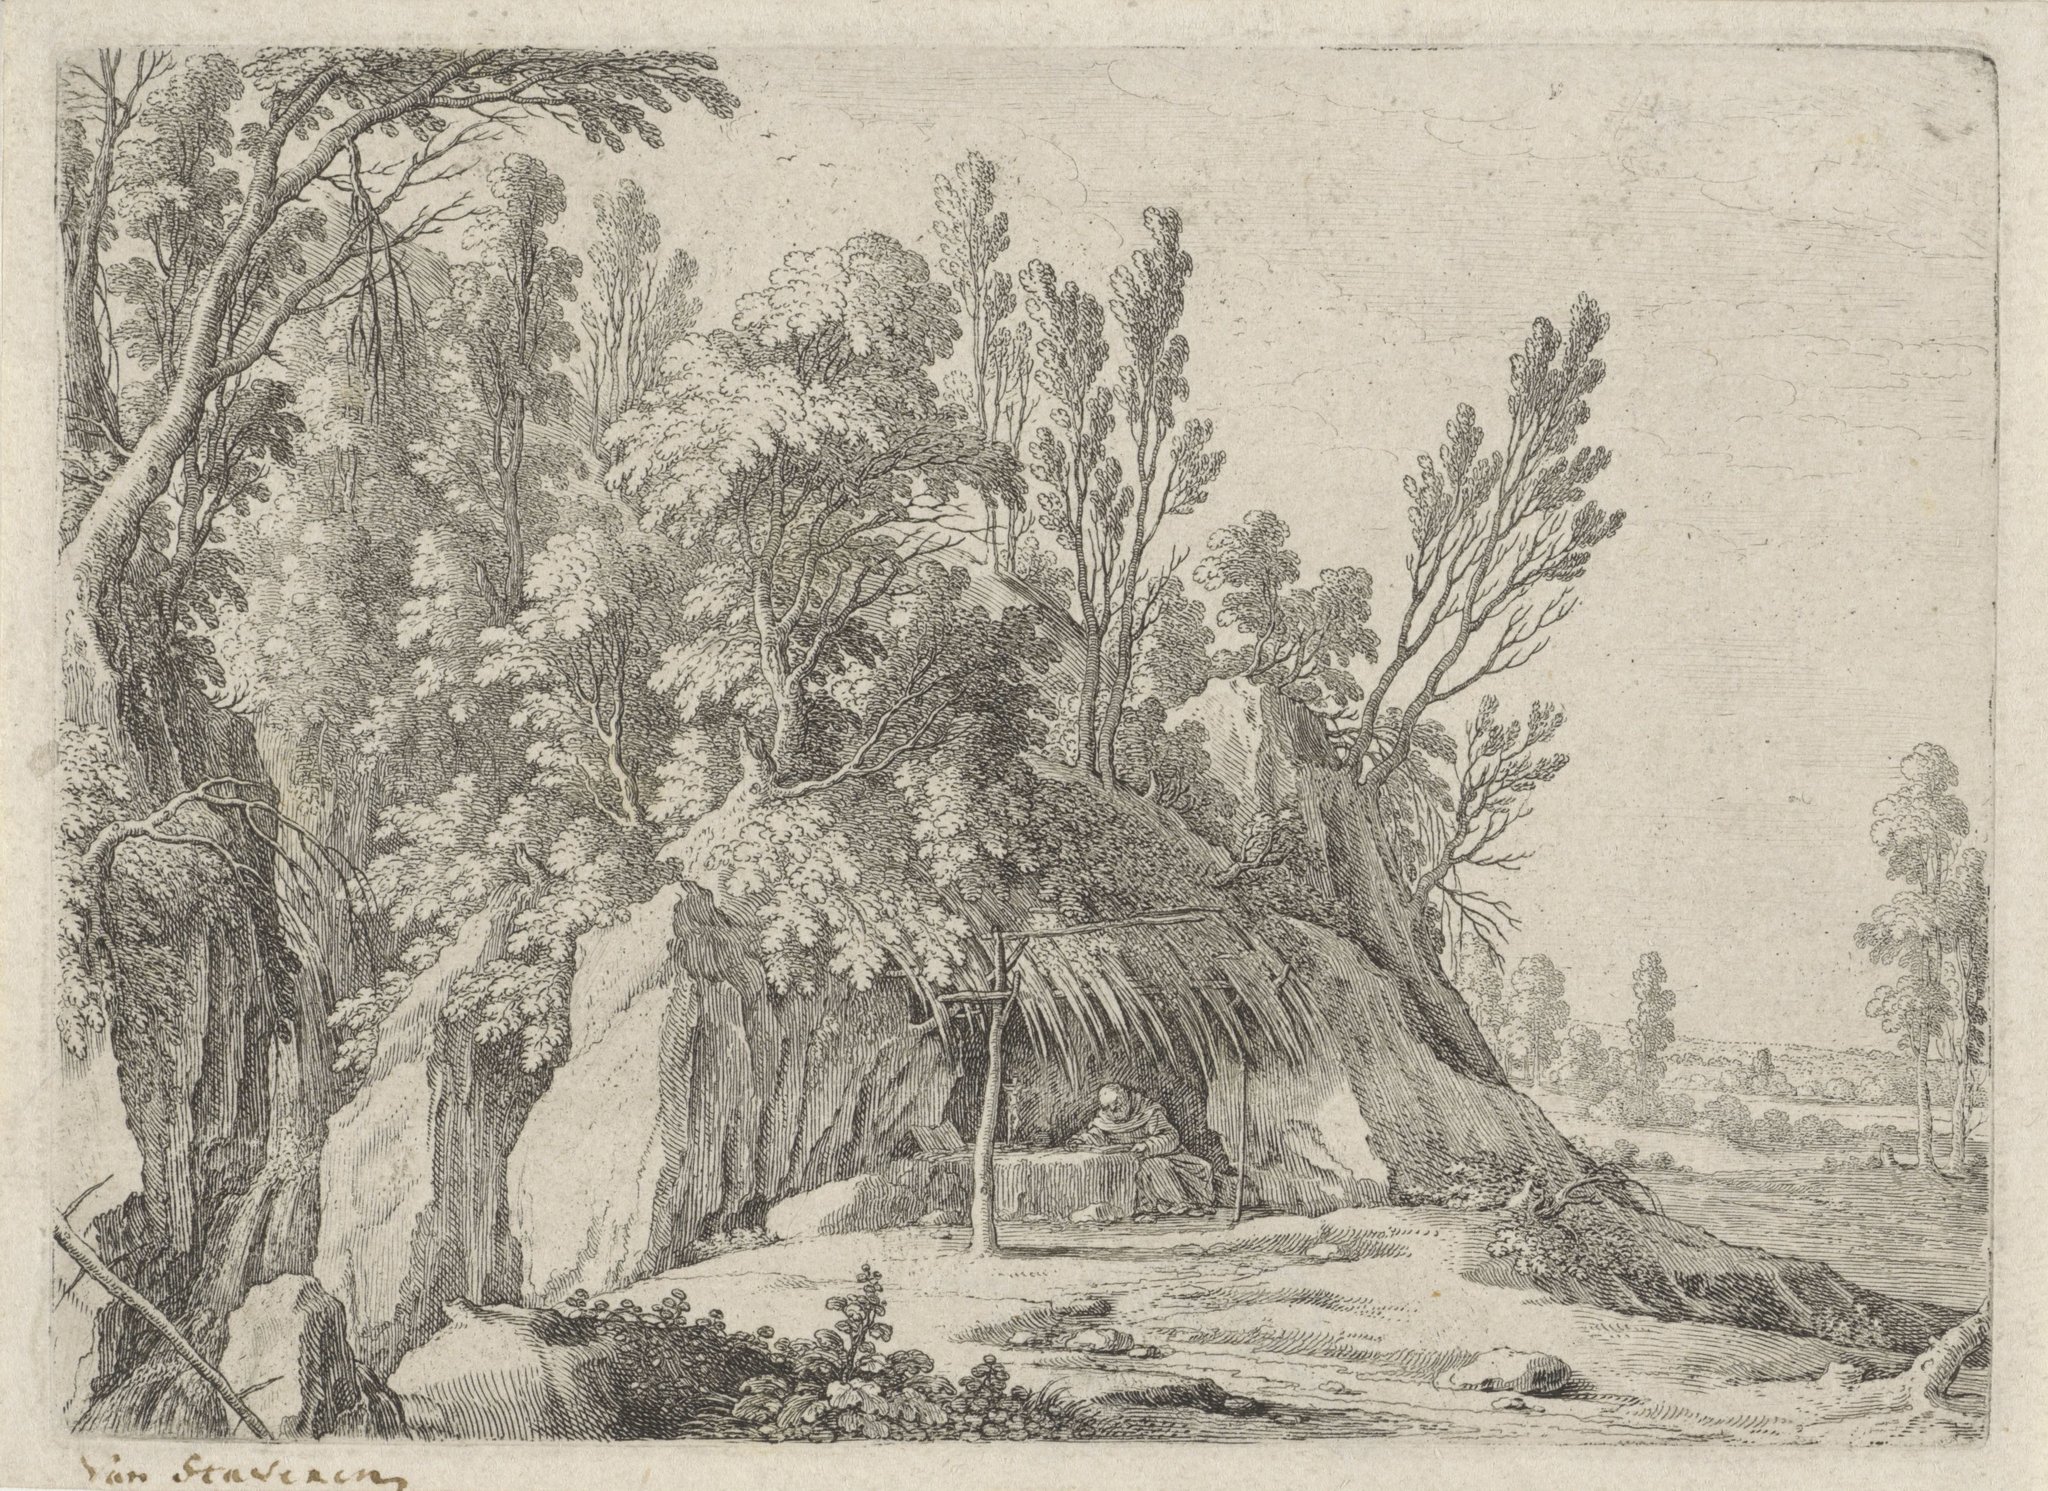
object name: print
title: Zeven landschappen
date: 1631-1656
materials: paper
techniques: engraving, etching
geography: amsterdam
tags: reading, anchorite, hermit, cave, grotto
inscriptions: collector's mark: Lugt 514, collector's mark: Lugt 2228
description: In een rotsachtig landschap zit een kluizenaar onder een met stro bedekt afdak voor een grot. Hij leest een boek. De prent maakt deel uit van een serie van zeven landschappen.